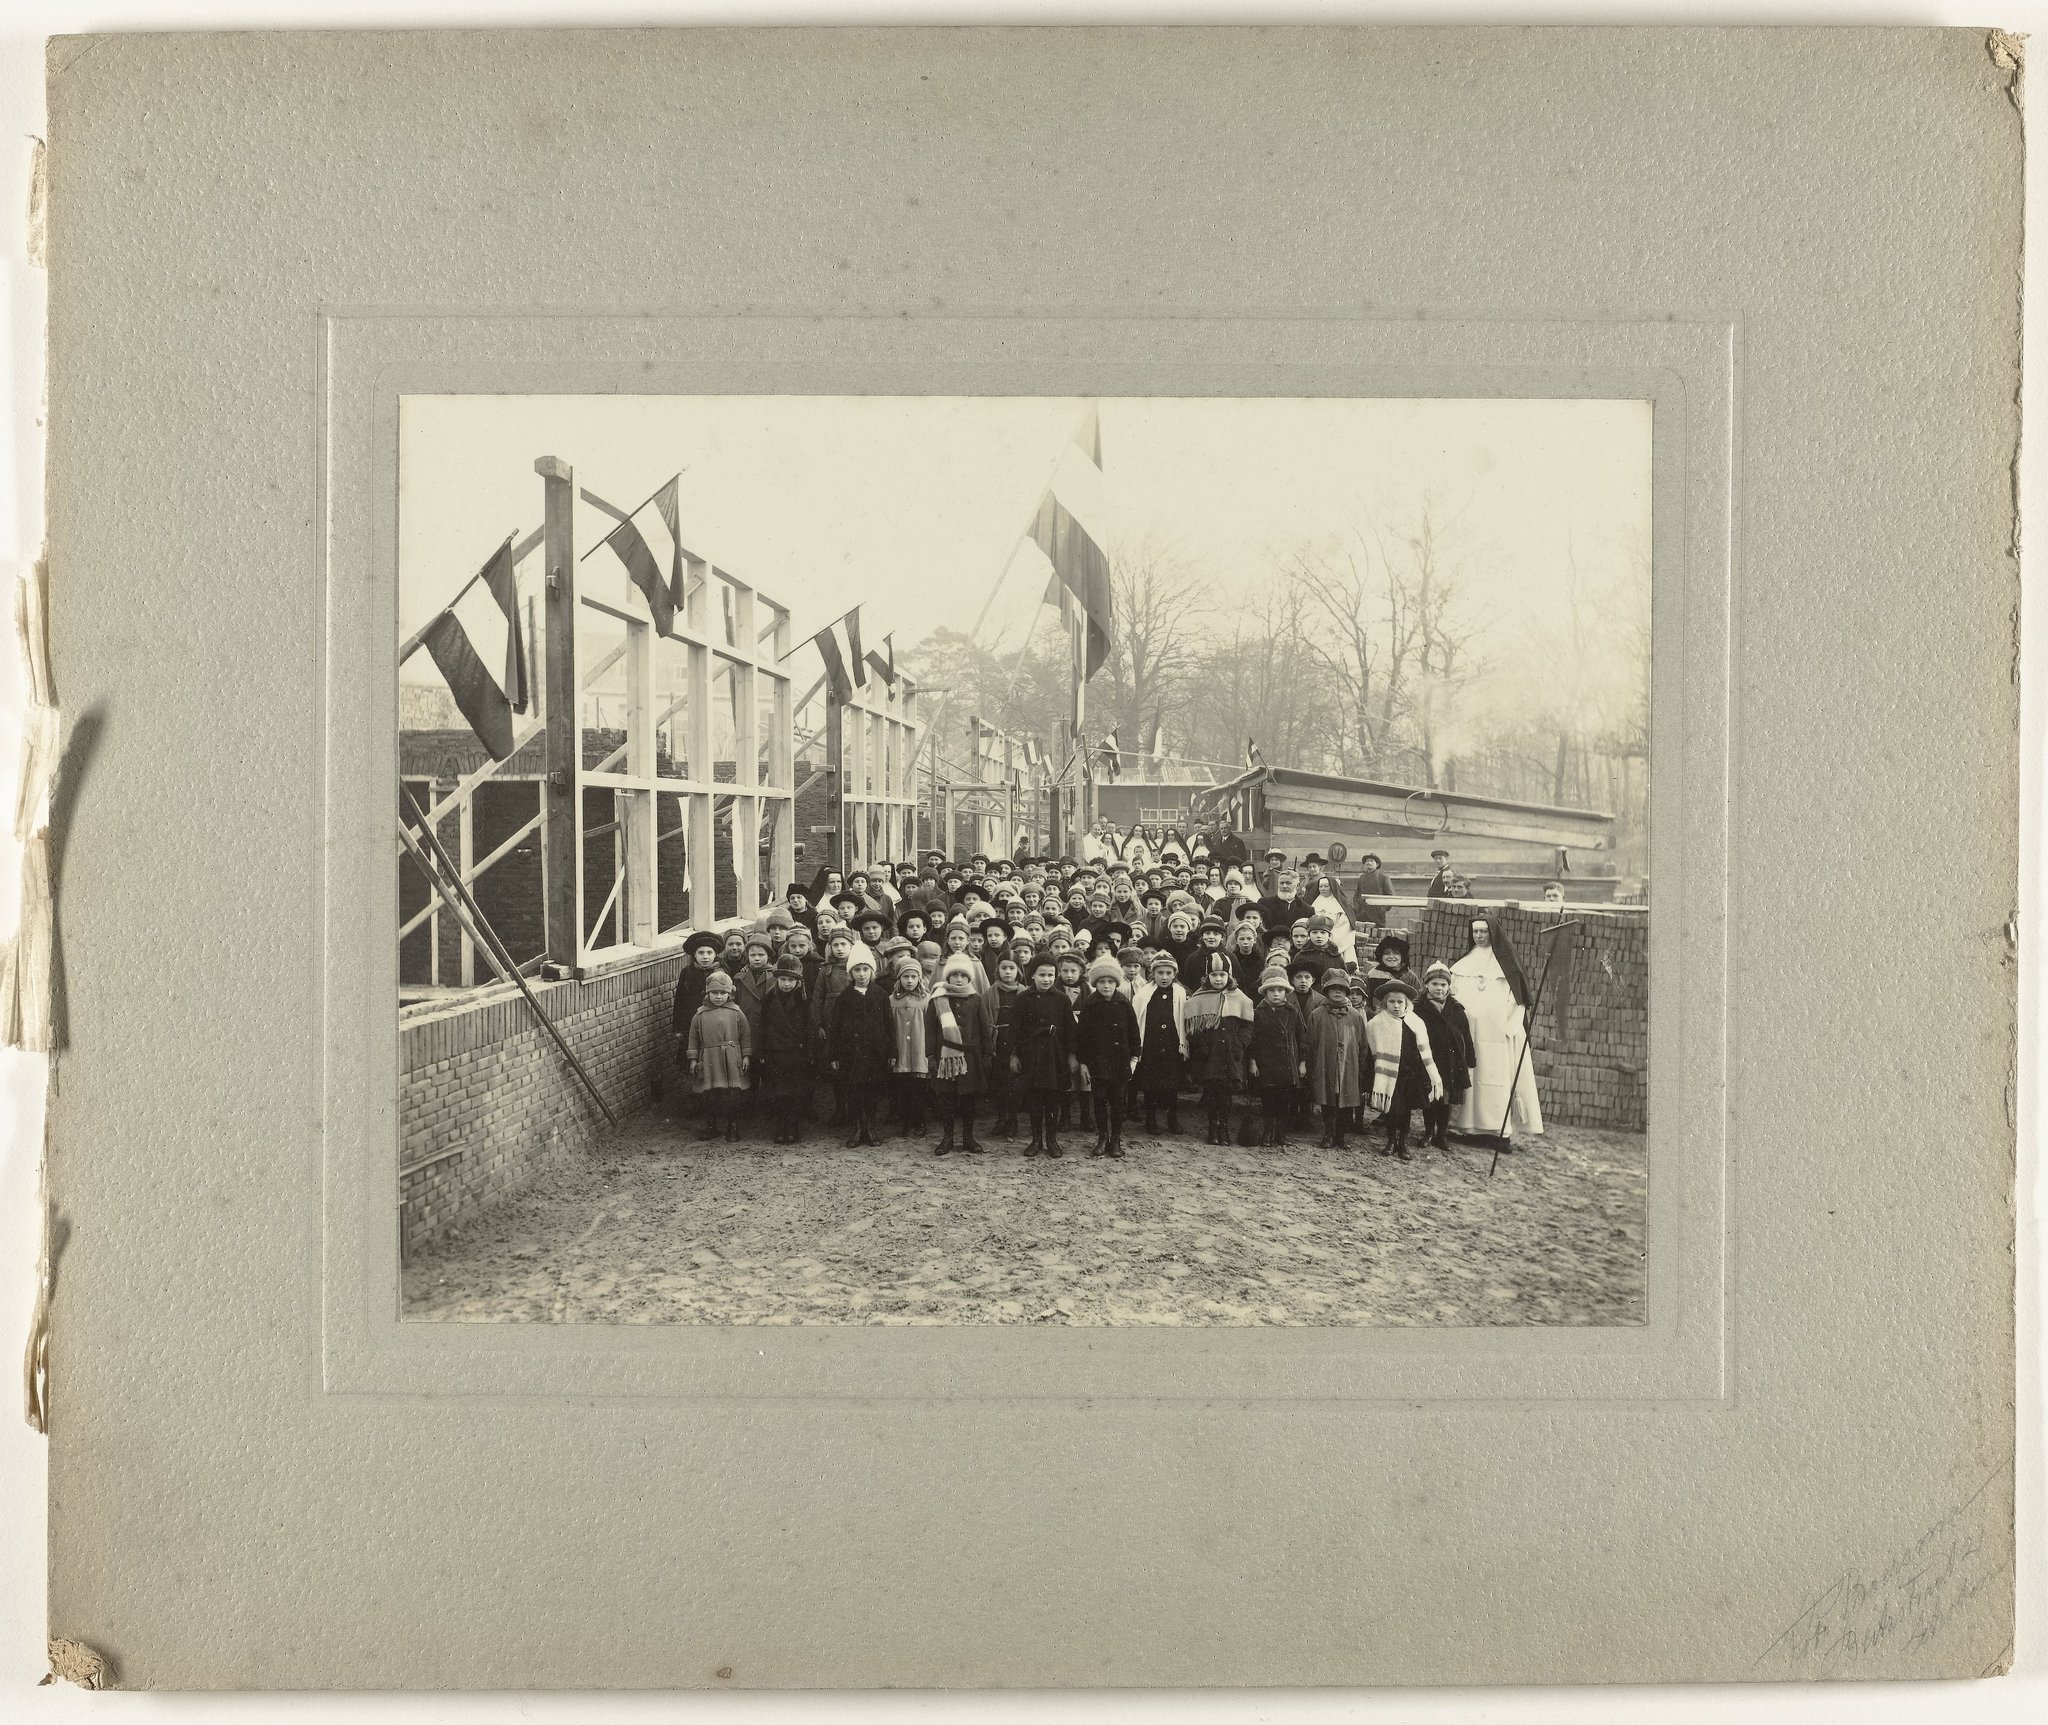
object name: photograph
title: Inzegening lagere school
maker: boersma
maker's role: fotograaf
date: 1920-1930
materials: photographic support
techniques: photography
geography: netherlands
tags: netherlands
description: Bij een school in aanbouw zijn katholieke geestelijken bezig de school te zegenen. Op de voorgrond een paar nonnen, daarachter kinderen. Aan de kozijnen hangen Nederlandse vlaggen.